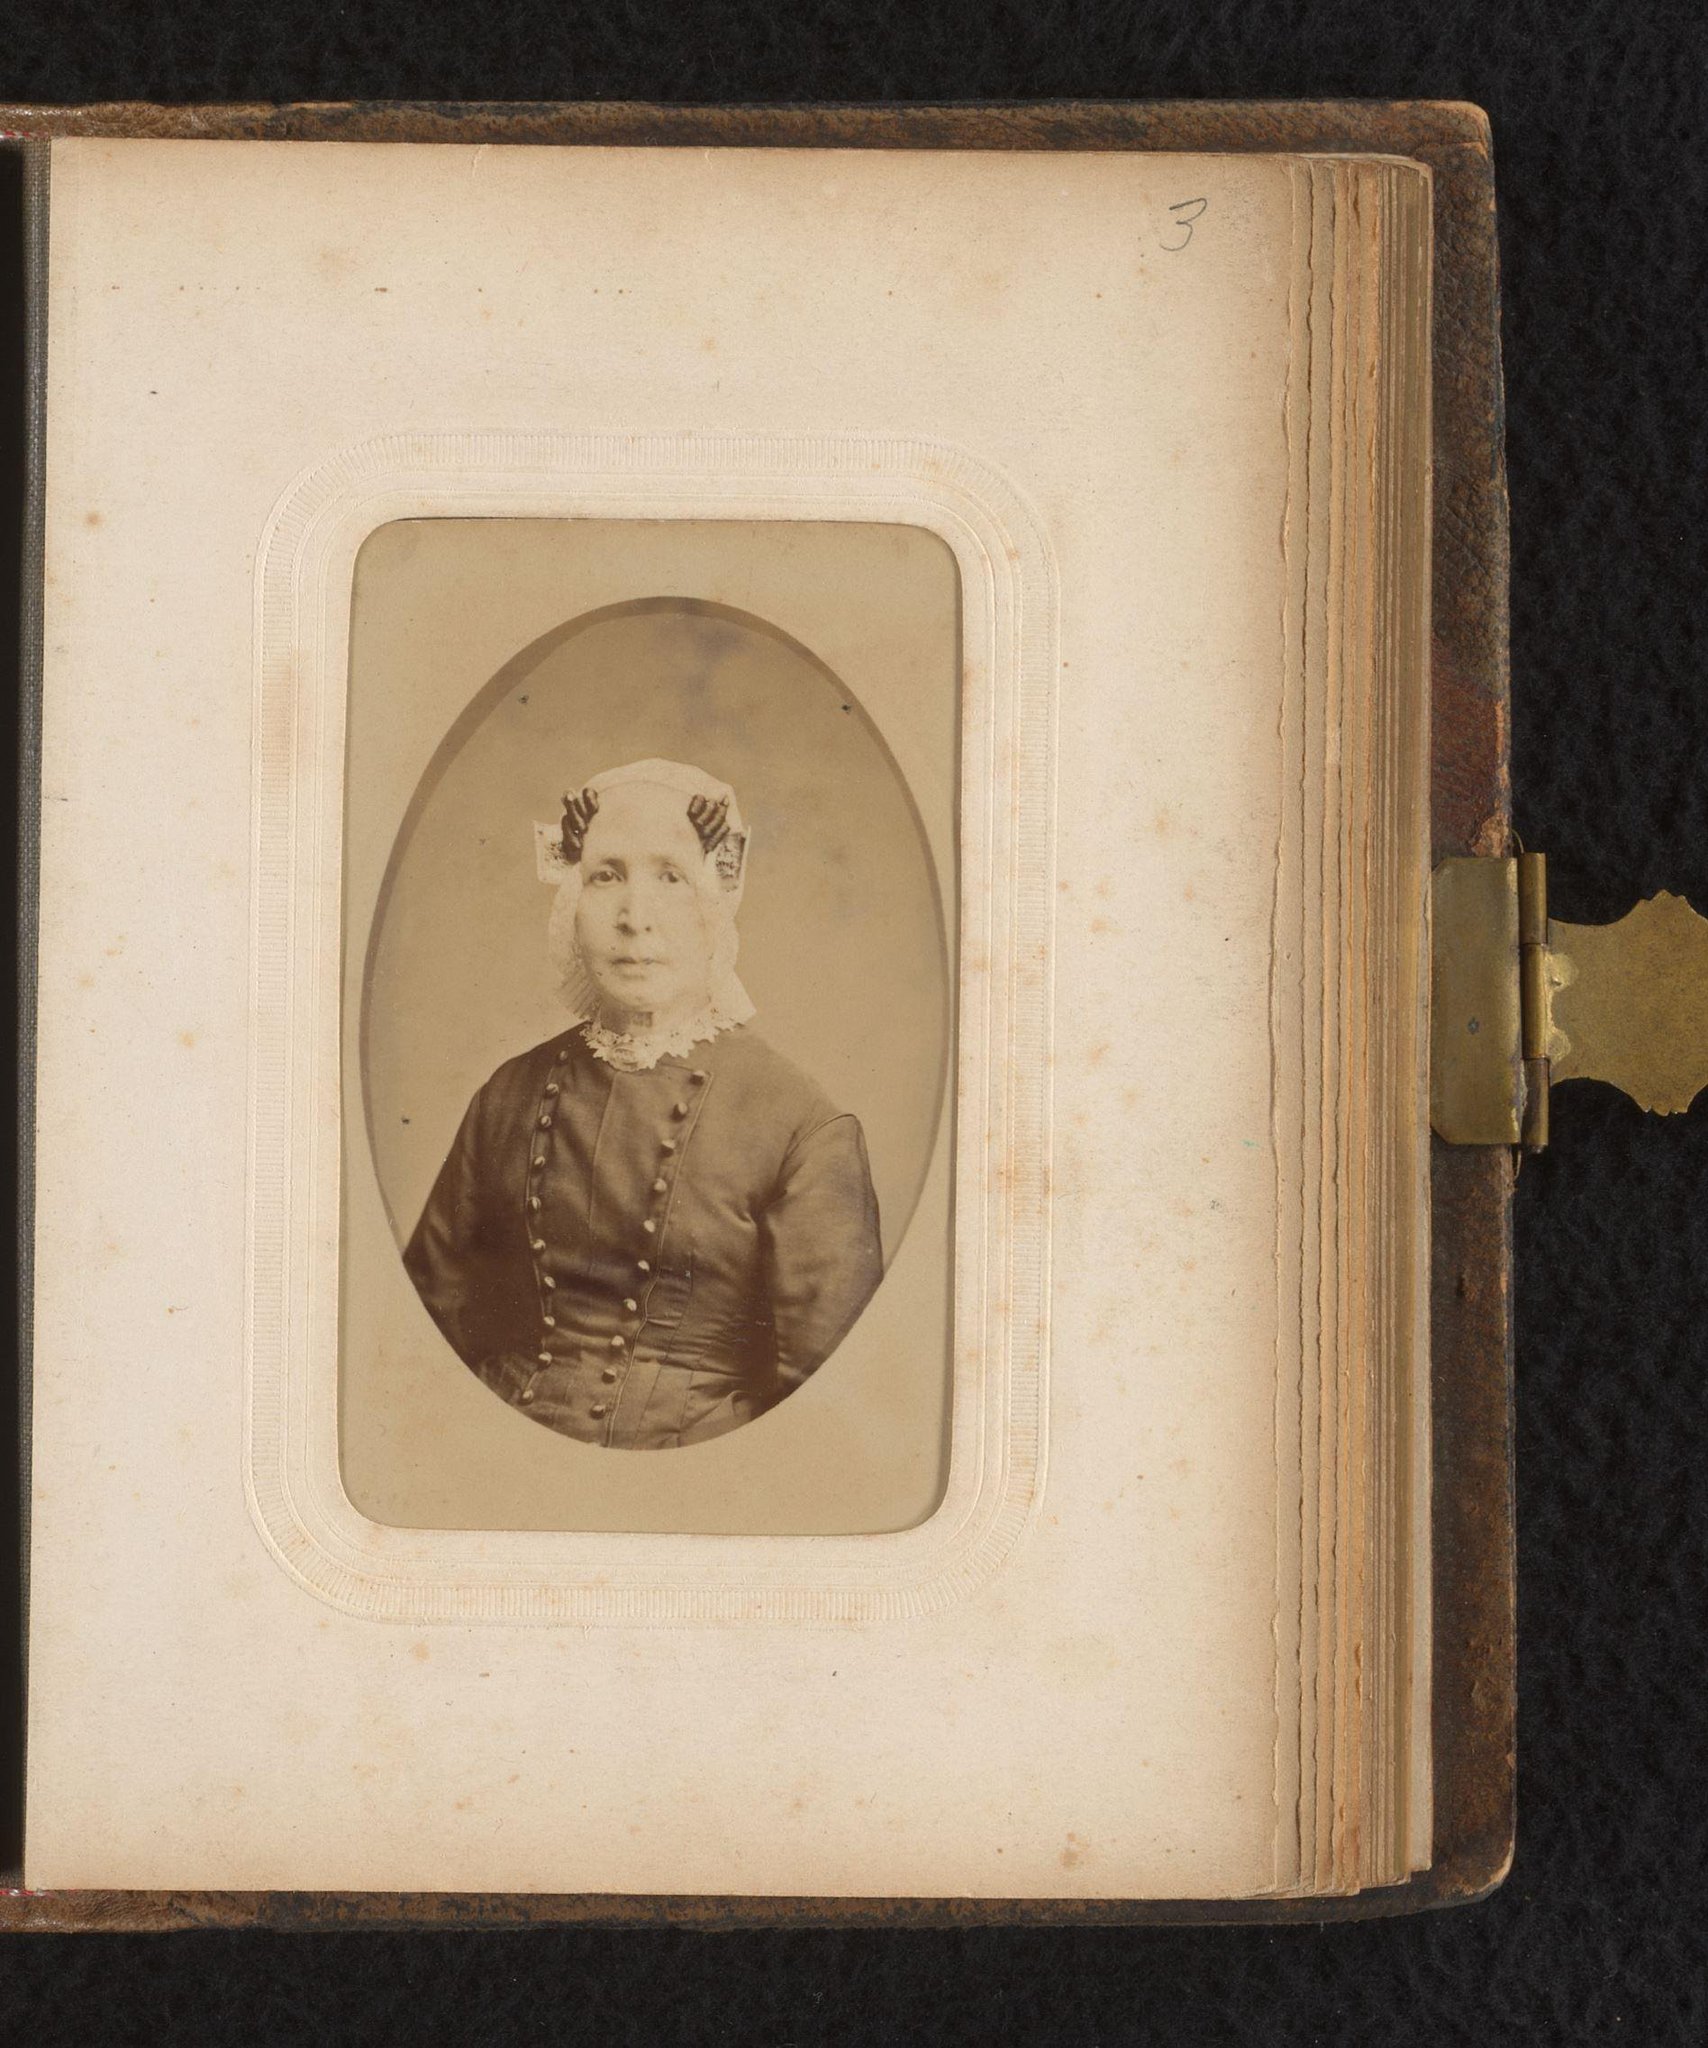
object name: photograph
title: Portret van Neeltje Bloemendaal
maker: jacob kuyper (1851-1919)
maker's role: fotograaf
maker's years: 1851-1919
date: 1878-1888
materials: cardboard, celluloid, paper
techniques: albumen print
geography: zaandam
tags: historical persons - bb - woman, folk costume, regional costume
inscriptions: inscription: ‘J. Kuyper/ voorheen: J. Breebaard (...) Noorderkerkpad.’, inscription: ‘?’